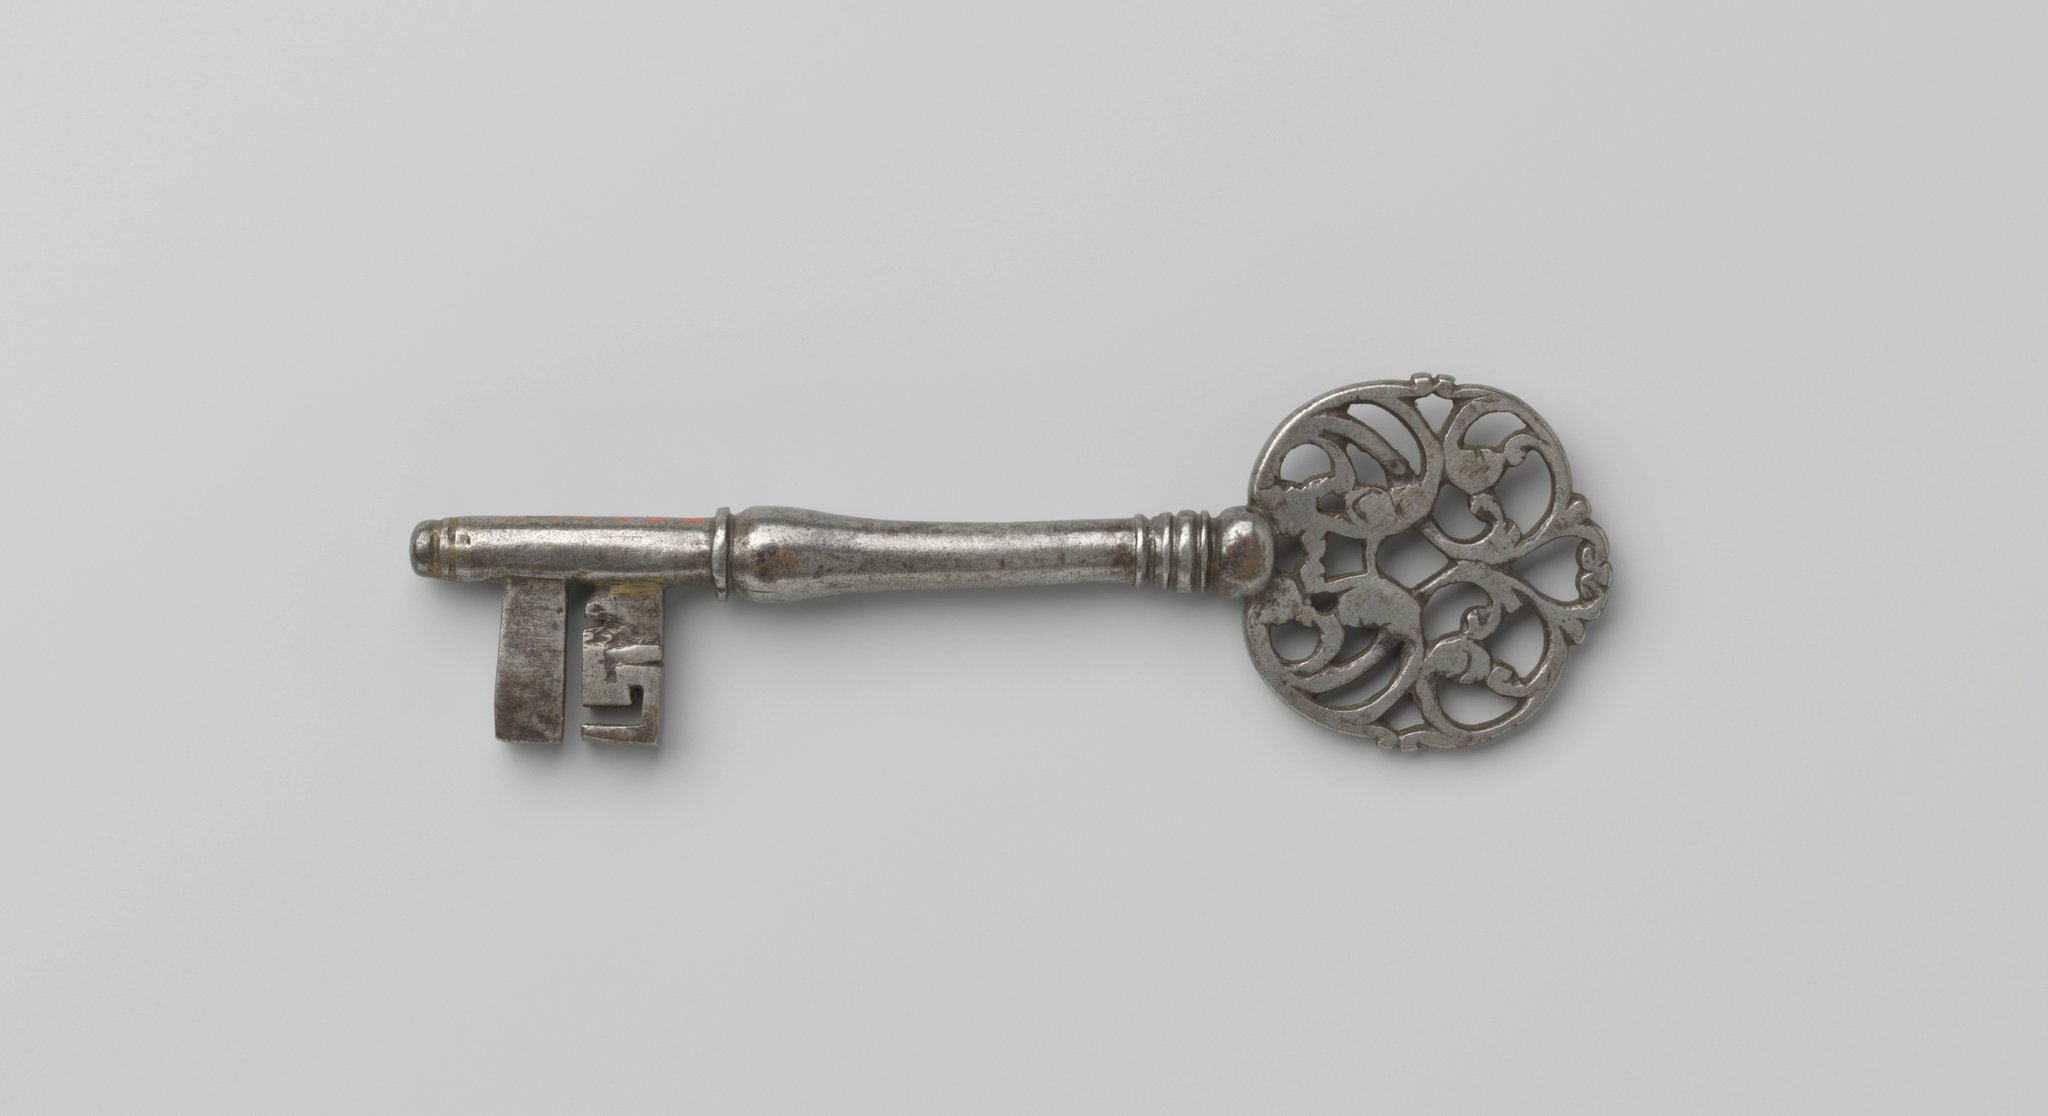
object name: key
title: Sleutel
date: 1400-1950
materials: iron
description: Sleutel met balustervormige schacht die iets onder de tweeledige baard doorloopt. De ronde greep is gevormd door opengewerkt acanthusblad en rust op een kogelvormig kapiteel.